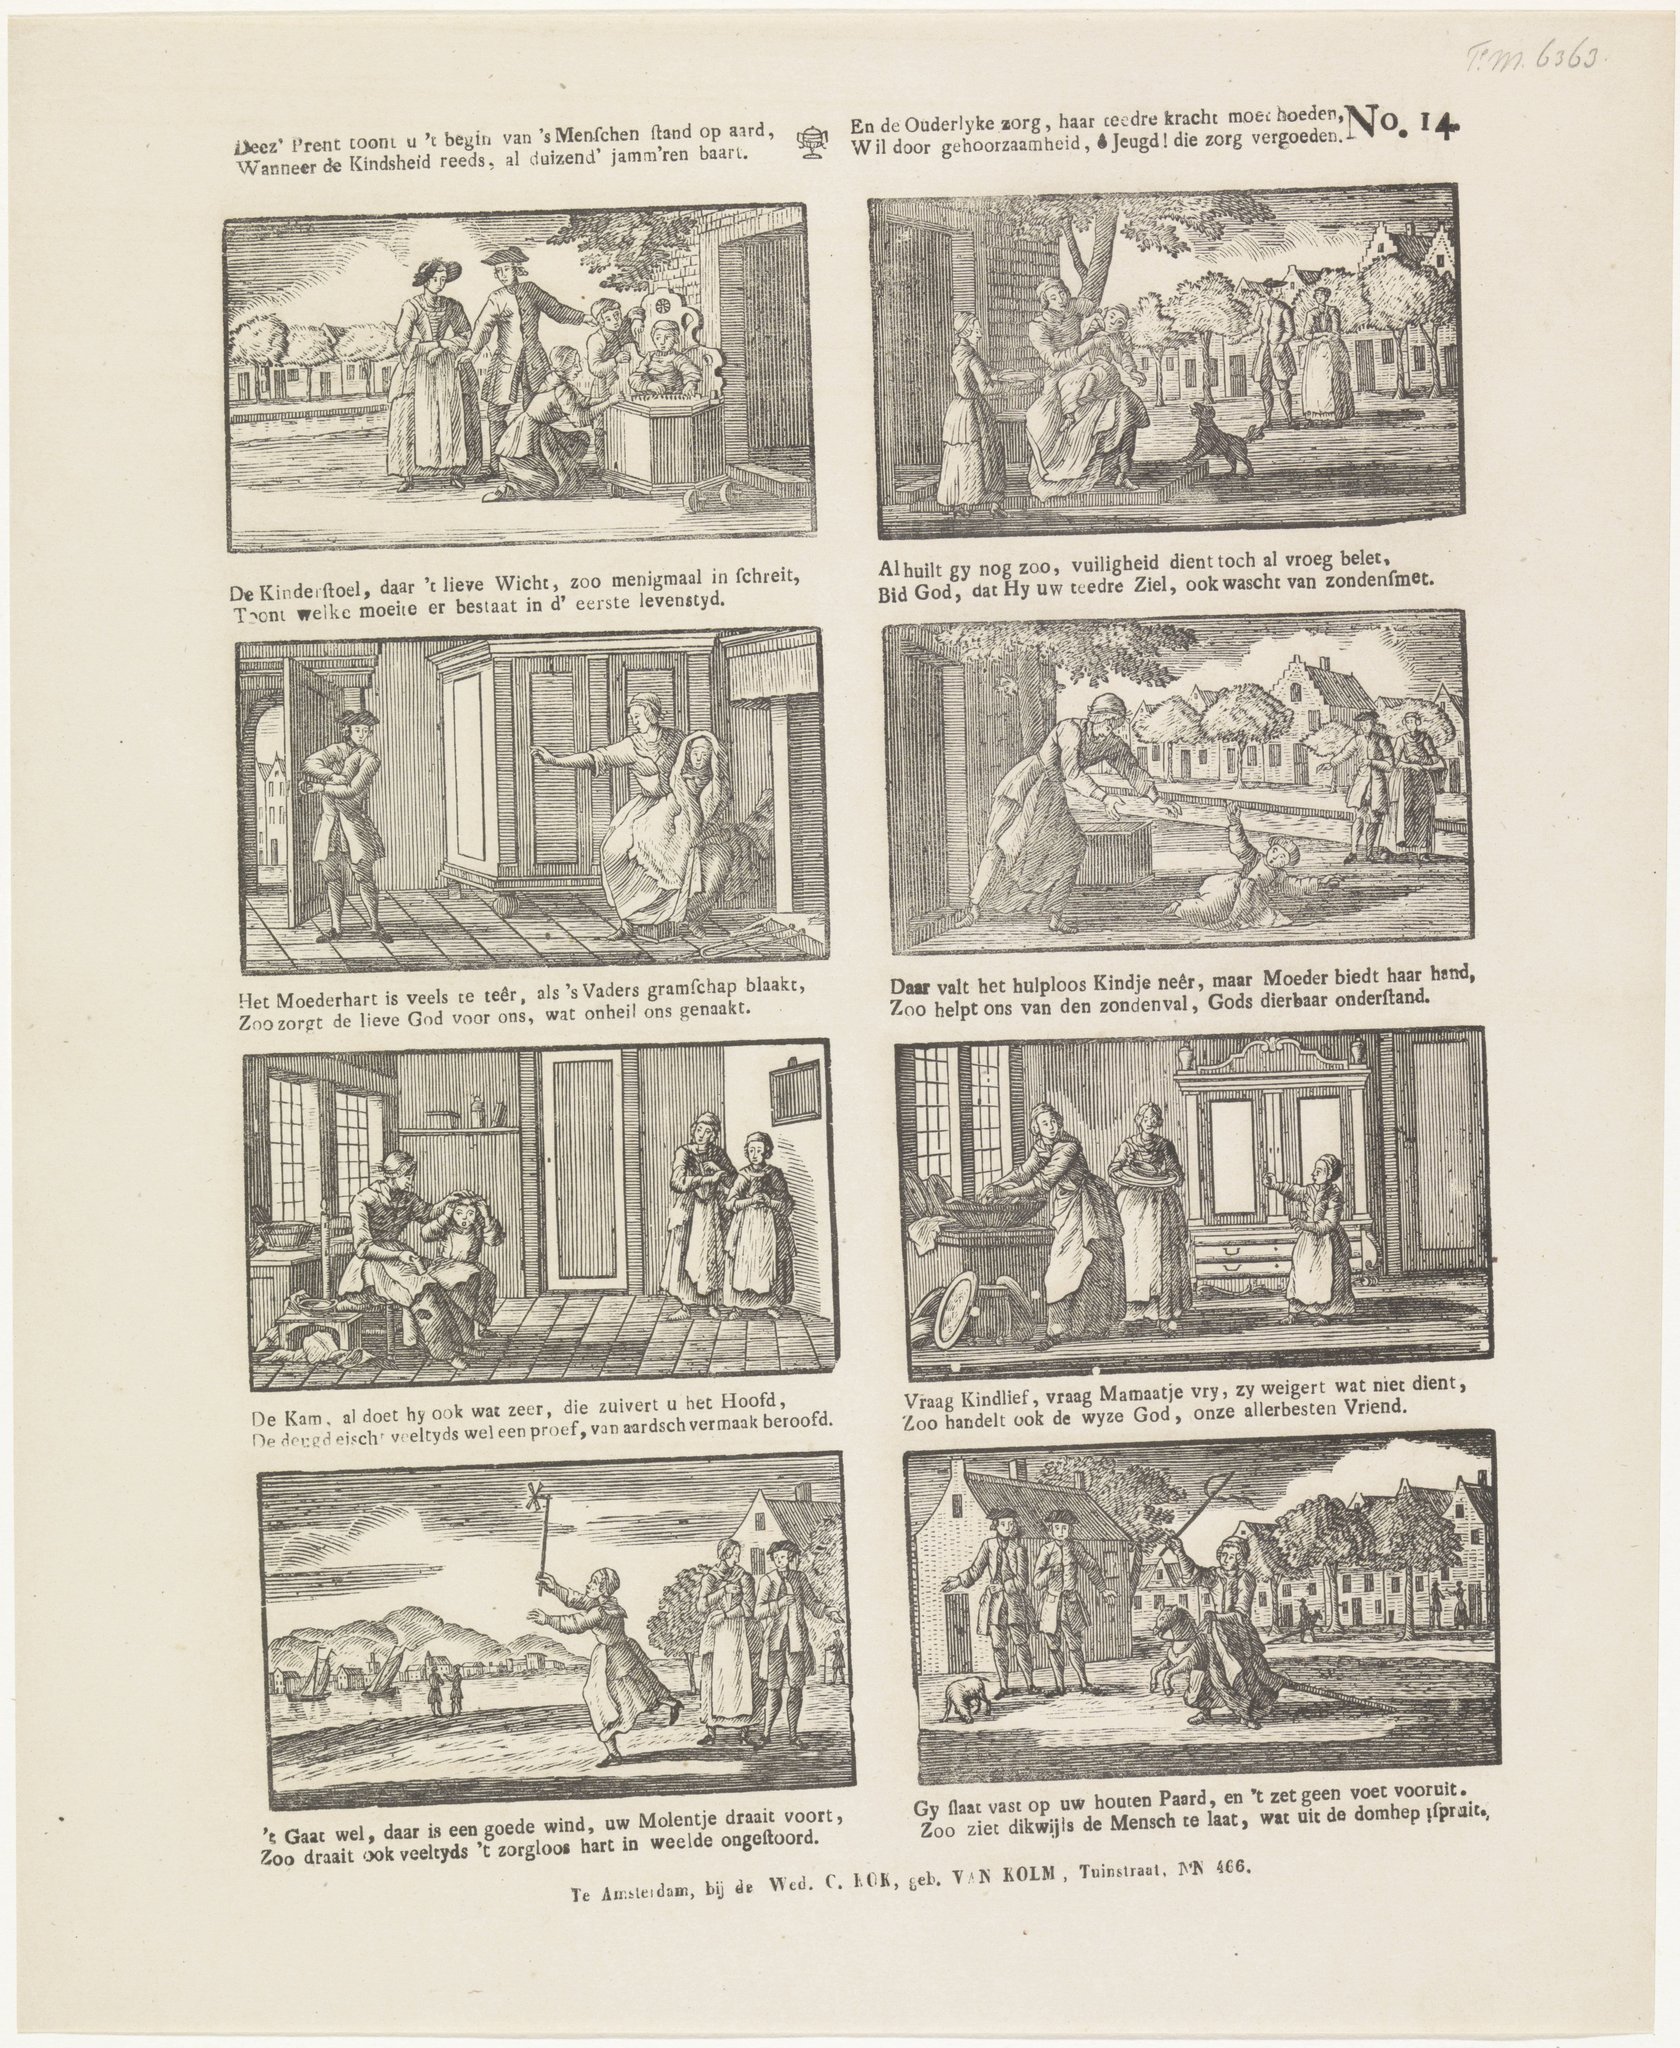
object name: popular print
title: Deez' Prent toont u 't begin van 's Menschen stand op aard, / Wanneer de Kindsheid reeds, al duizend' jamm'ren baart (...)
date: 1800-1850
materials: paper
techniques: letterpress printing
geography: amsterdam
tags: children's games and plays, growing up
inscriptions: collector's mark: Lugt 2228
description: Blad met acht voorstellingen van de kindertijd. Onder elk plaatje een tweeregelig versje. Ca. 1800-1850. Genummerd rechtsboven: No. 14.